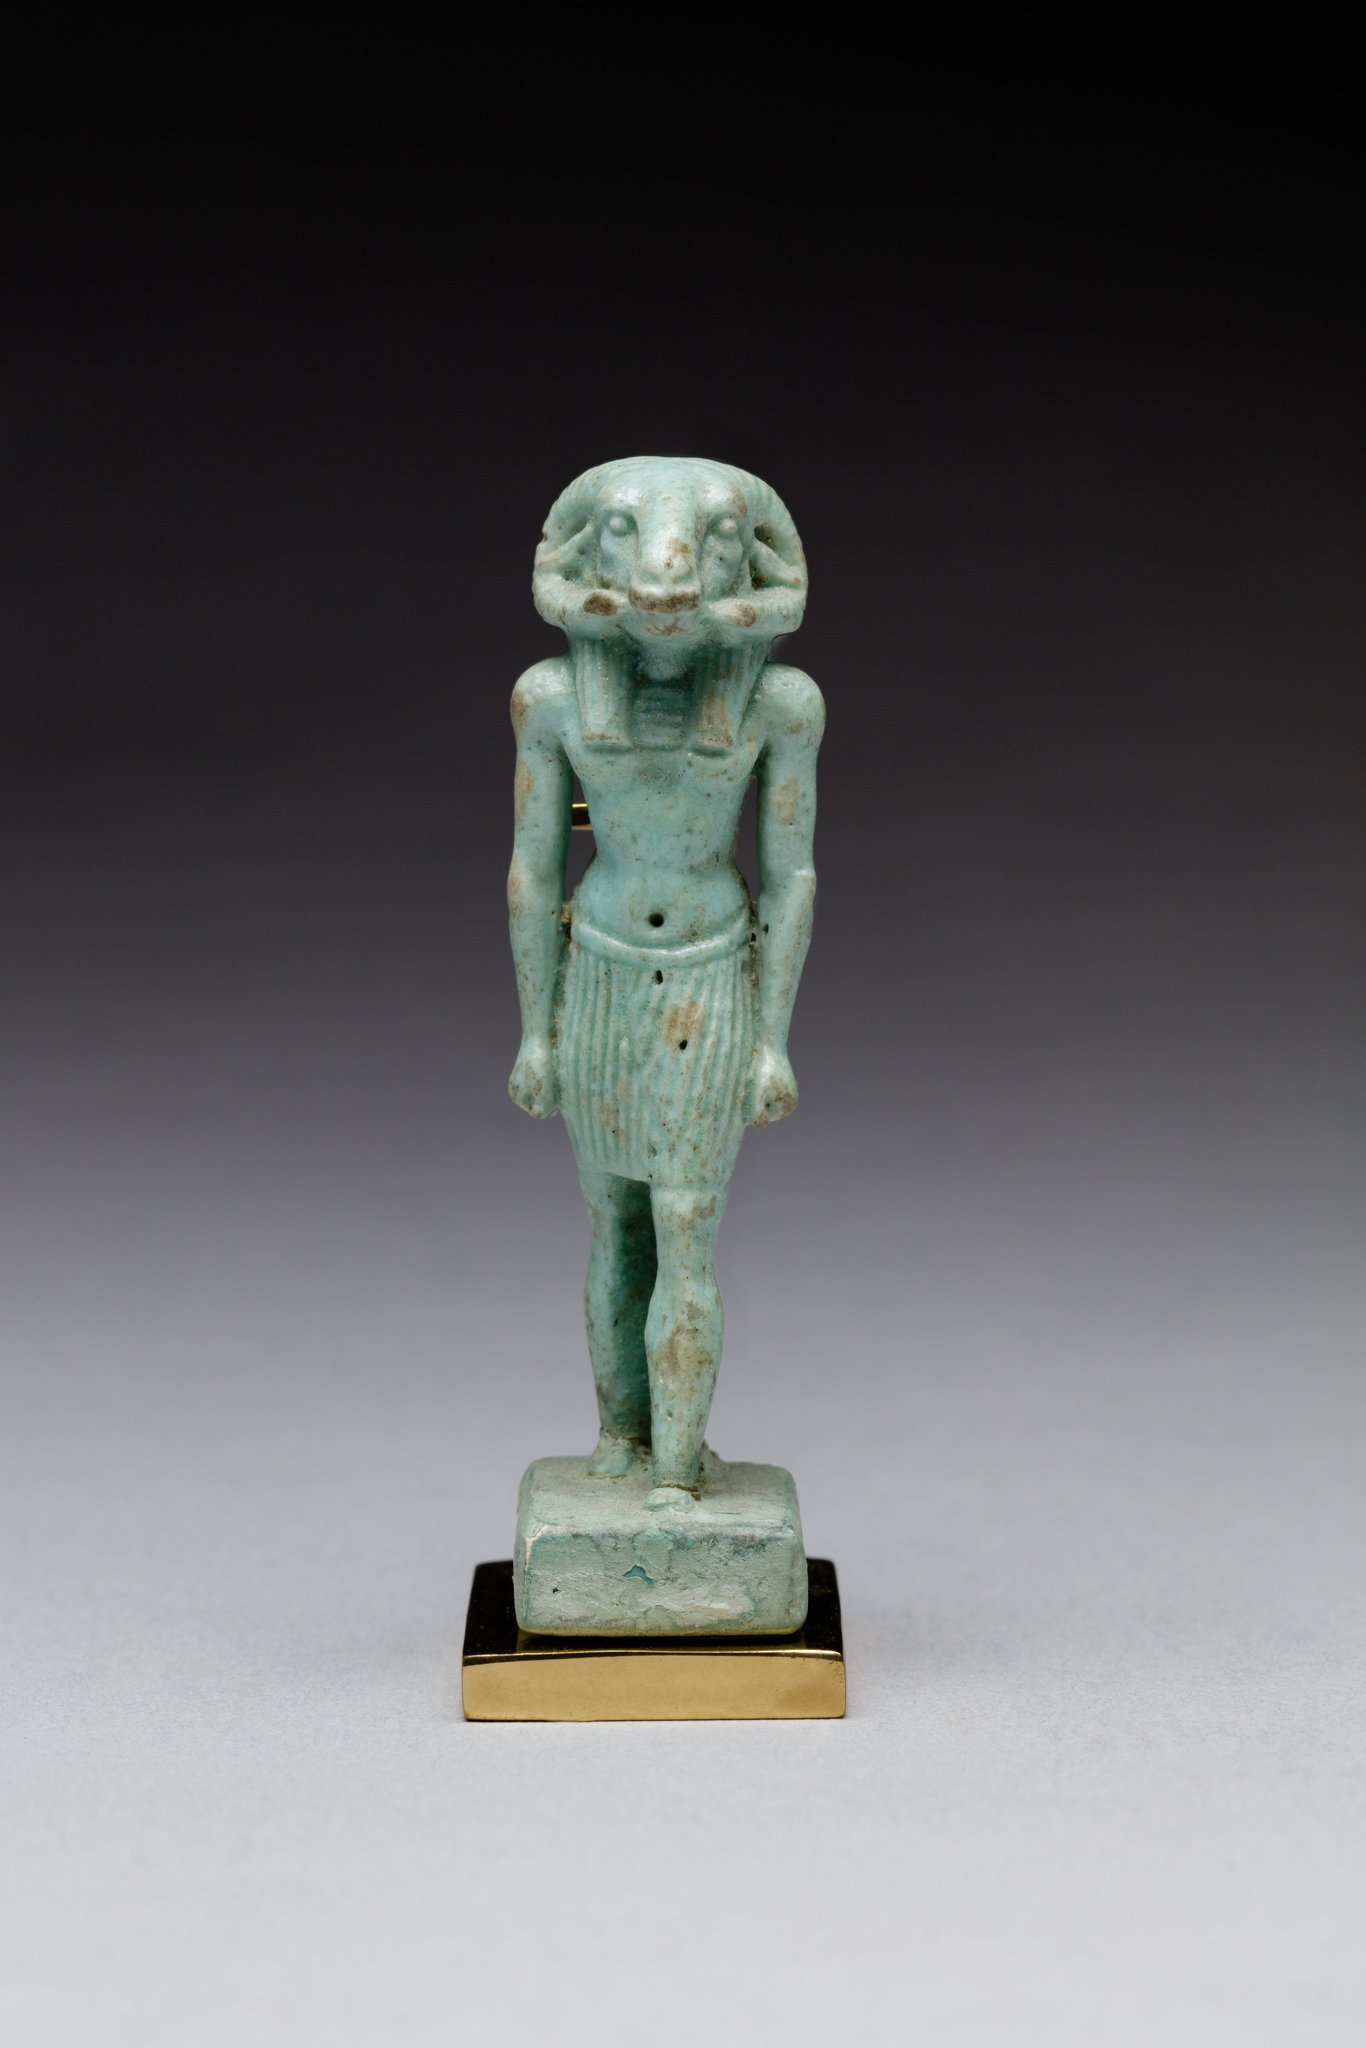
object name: amulet, god, ram headed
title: Amulet depicting a ram-headed god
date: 664-332 BCE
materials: faience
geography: egypt